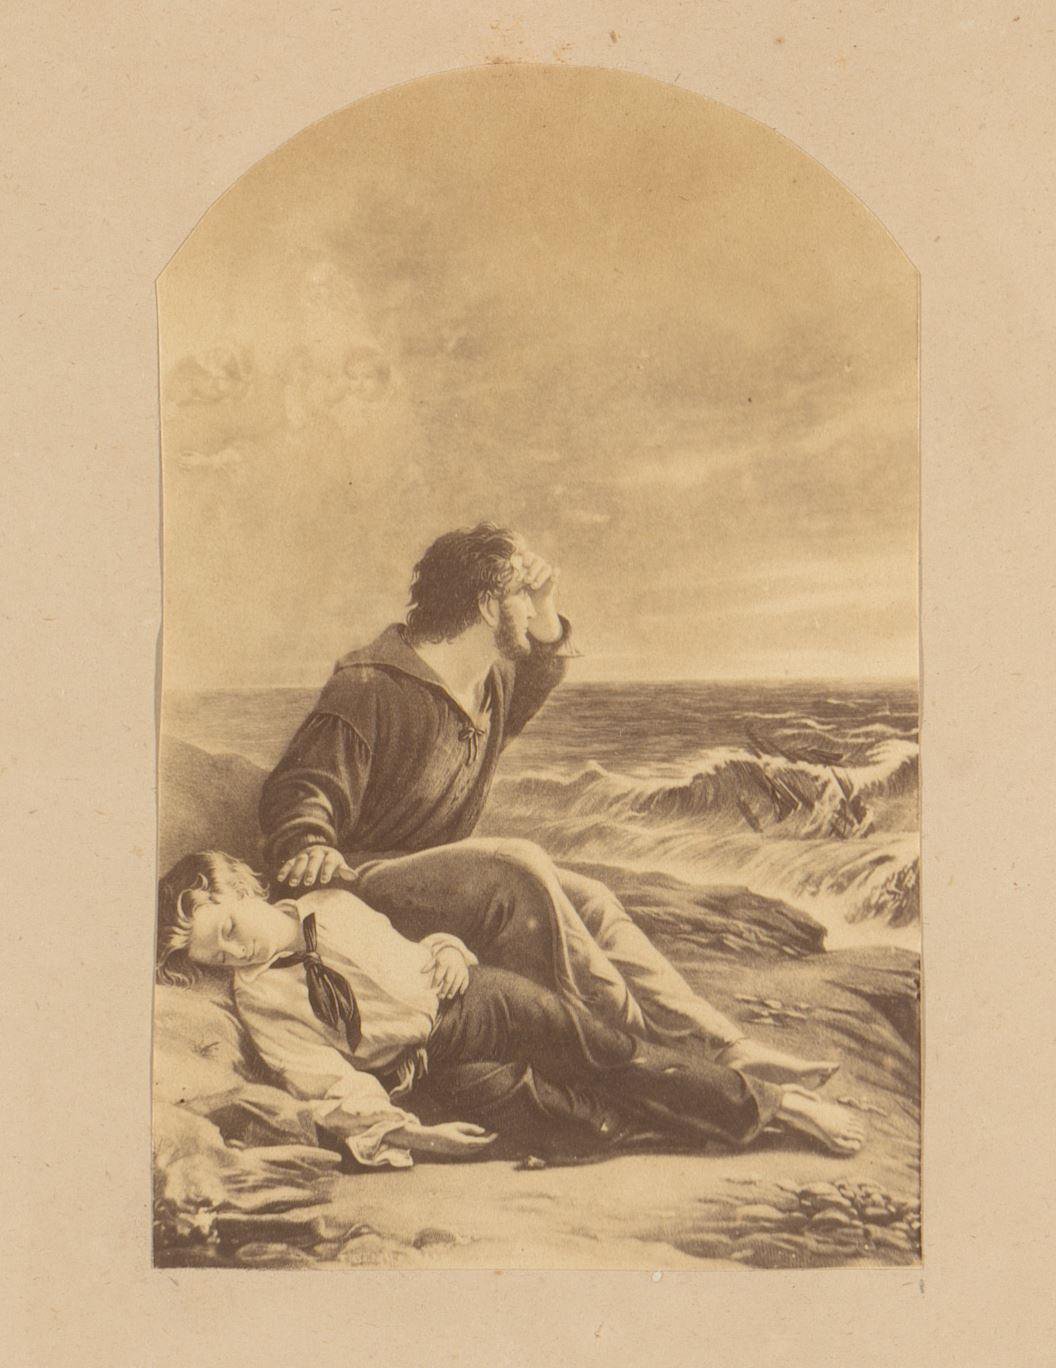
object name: photograph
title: Fotoreproductie van The Sailor Boy's Dream of Home door Thomas Brooks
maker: Anonymous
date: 1875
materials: photographic support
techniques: albumen print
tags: sailor, sea